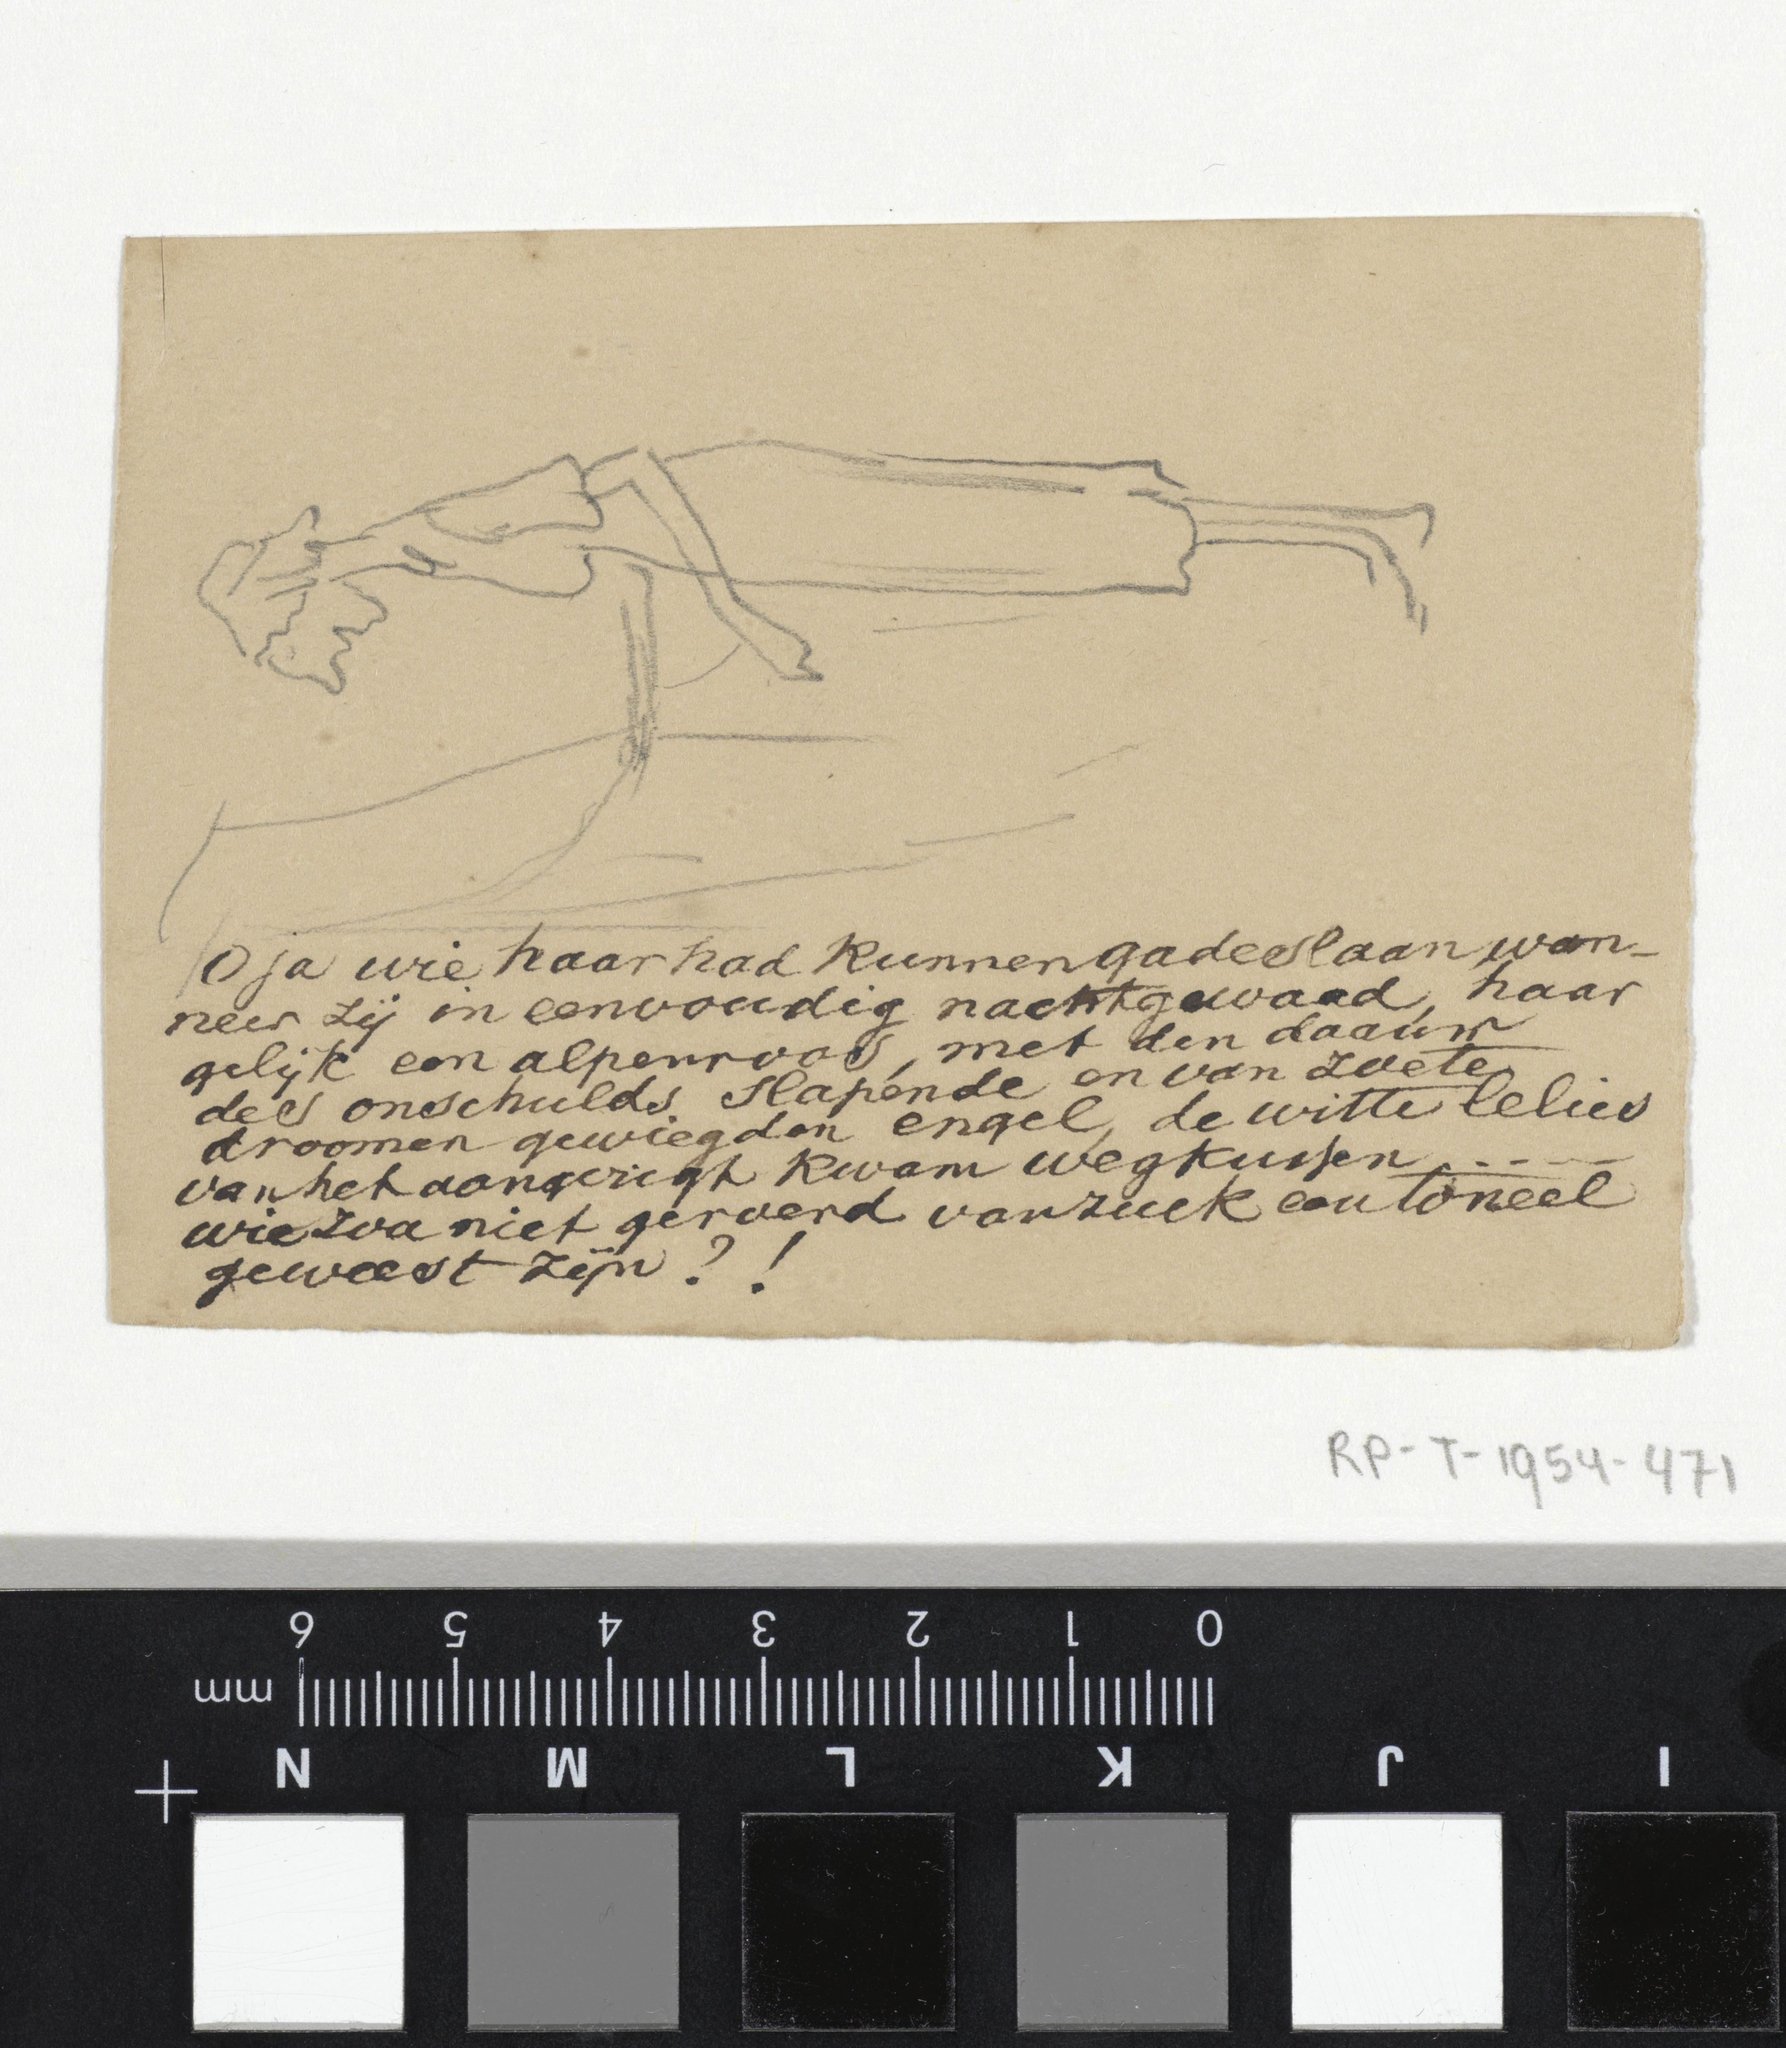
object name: drawing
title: Staande vrouw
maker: pieter van loon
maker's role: draughtsman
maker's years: 1801-1873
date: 1811-1873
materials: paper, pencil